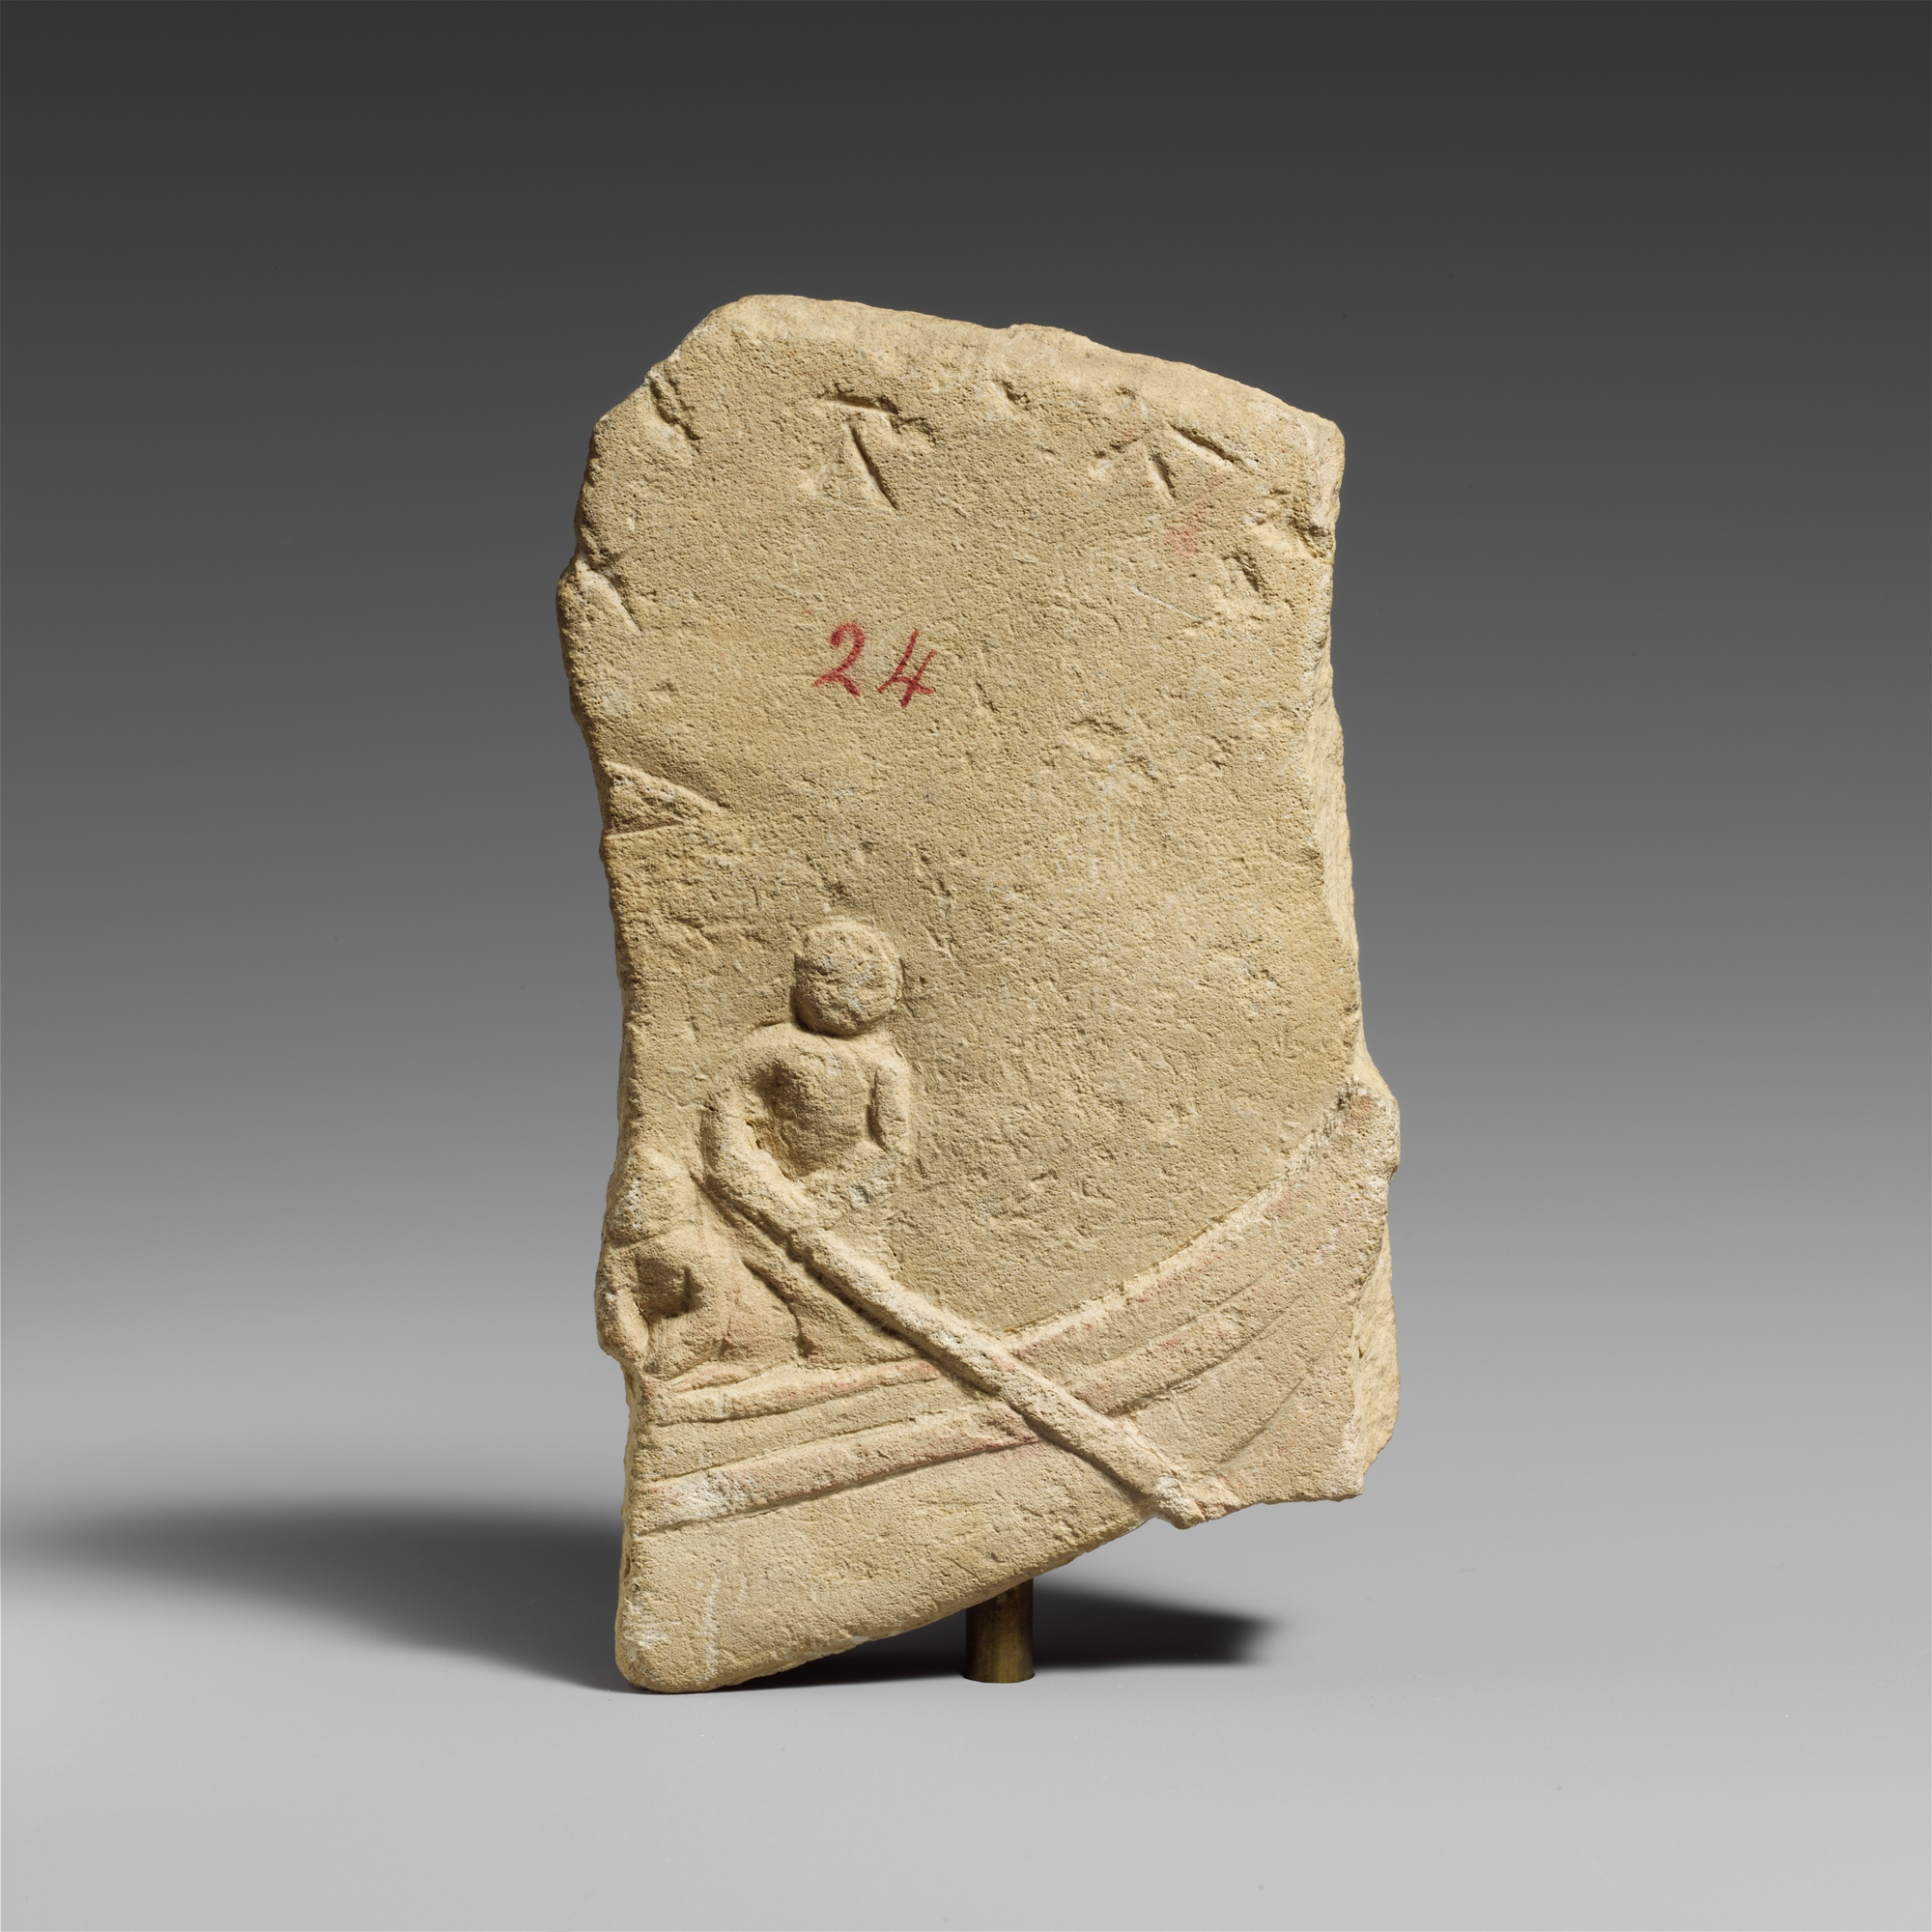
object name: relief, votive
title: Fragment of a limestone votive relief with a boat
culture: cypriot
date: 300-250 BCE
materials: limestone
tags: human figures,boats